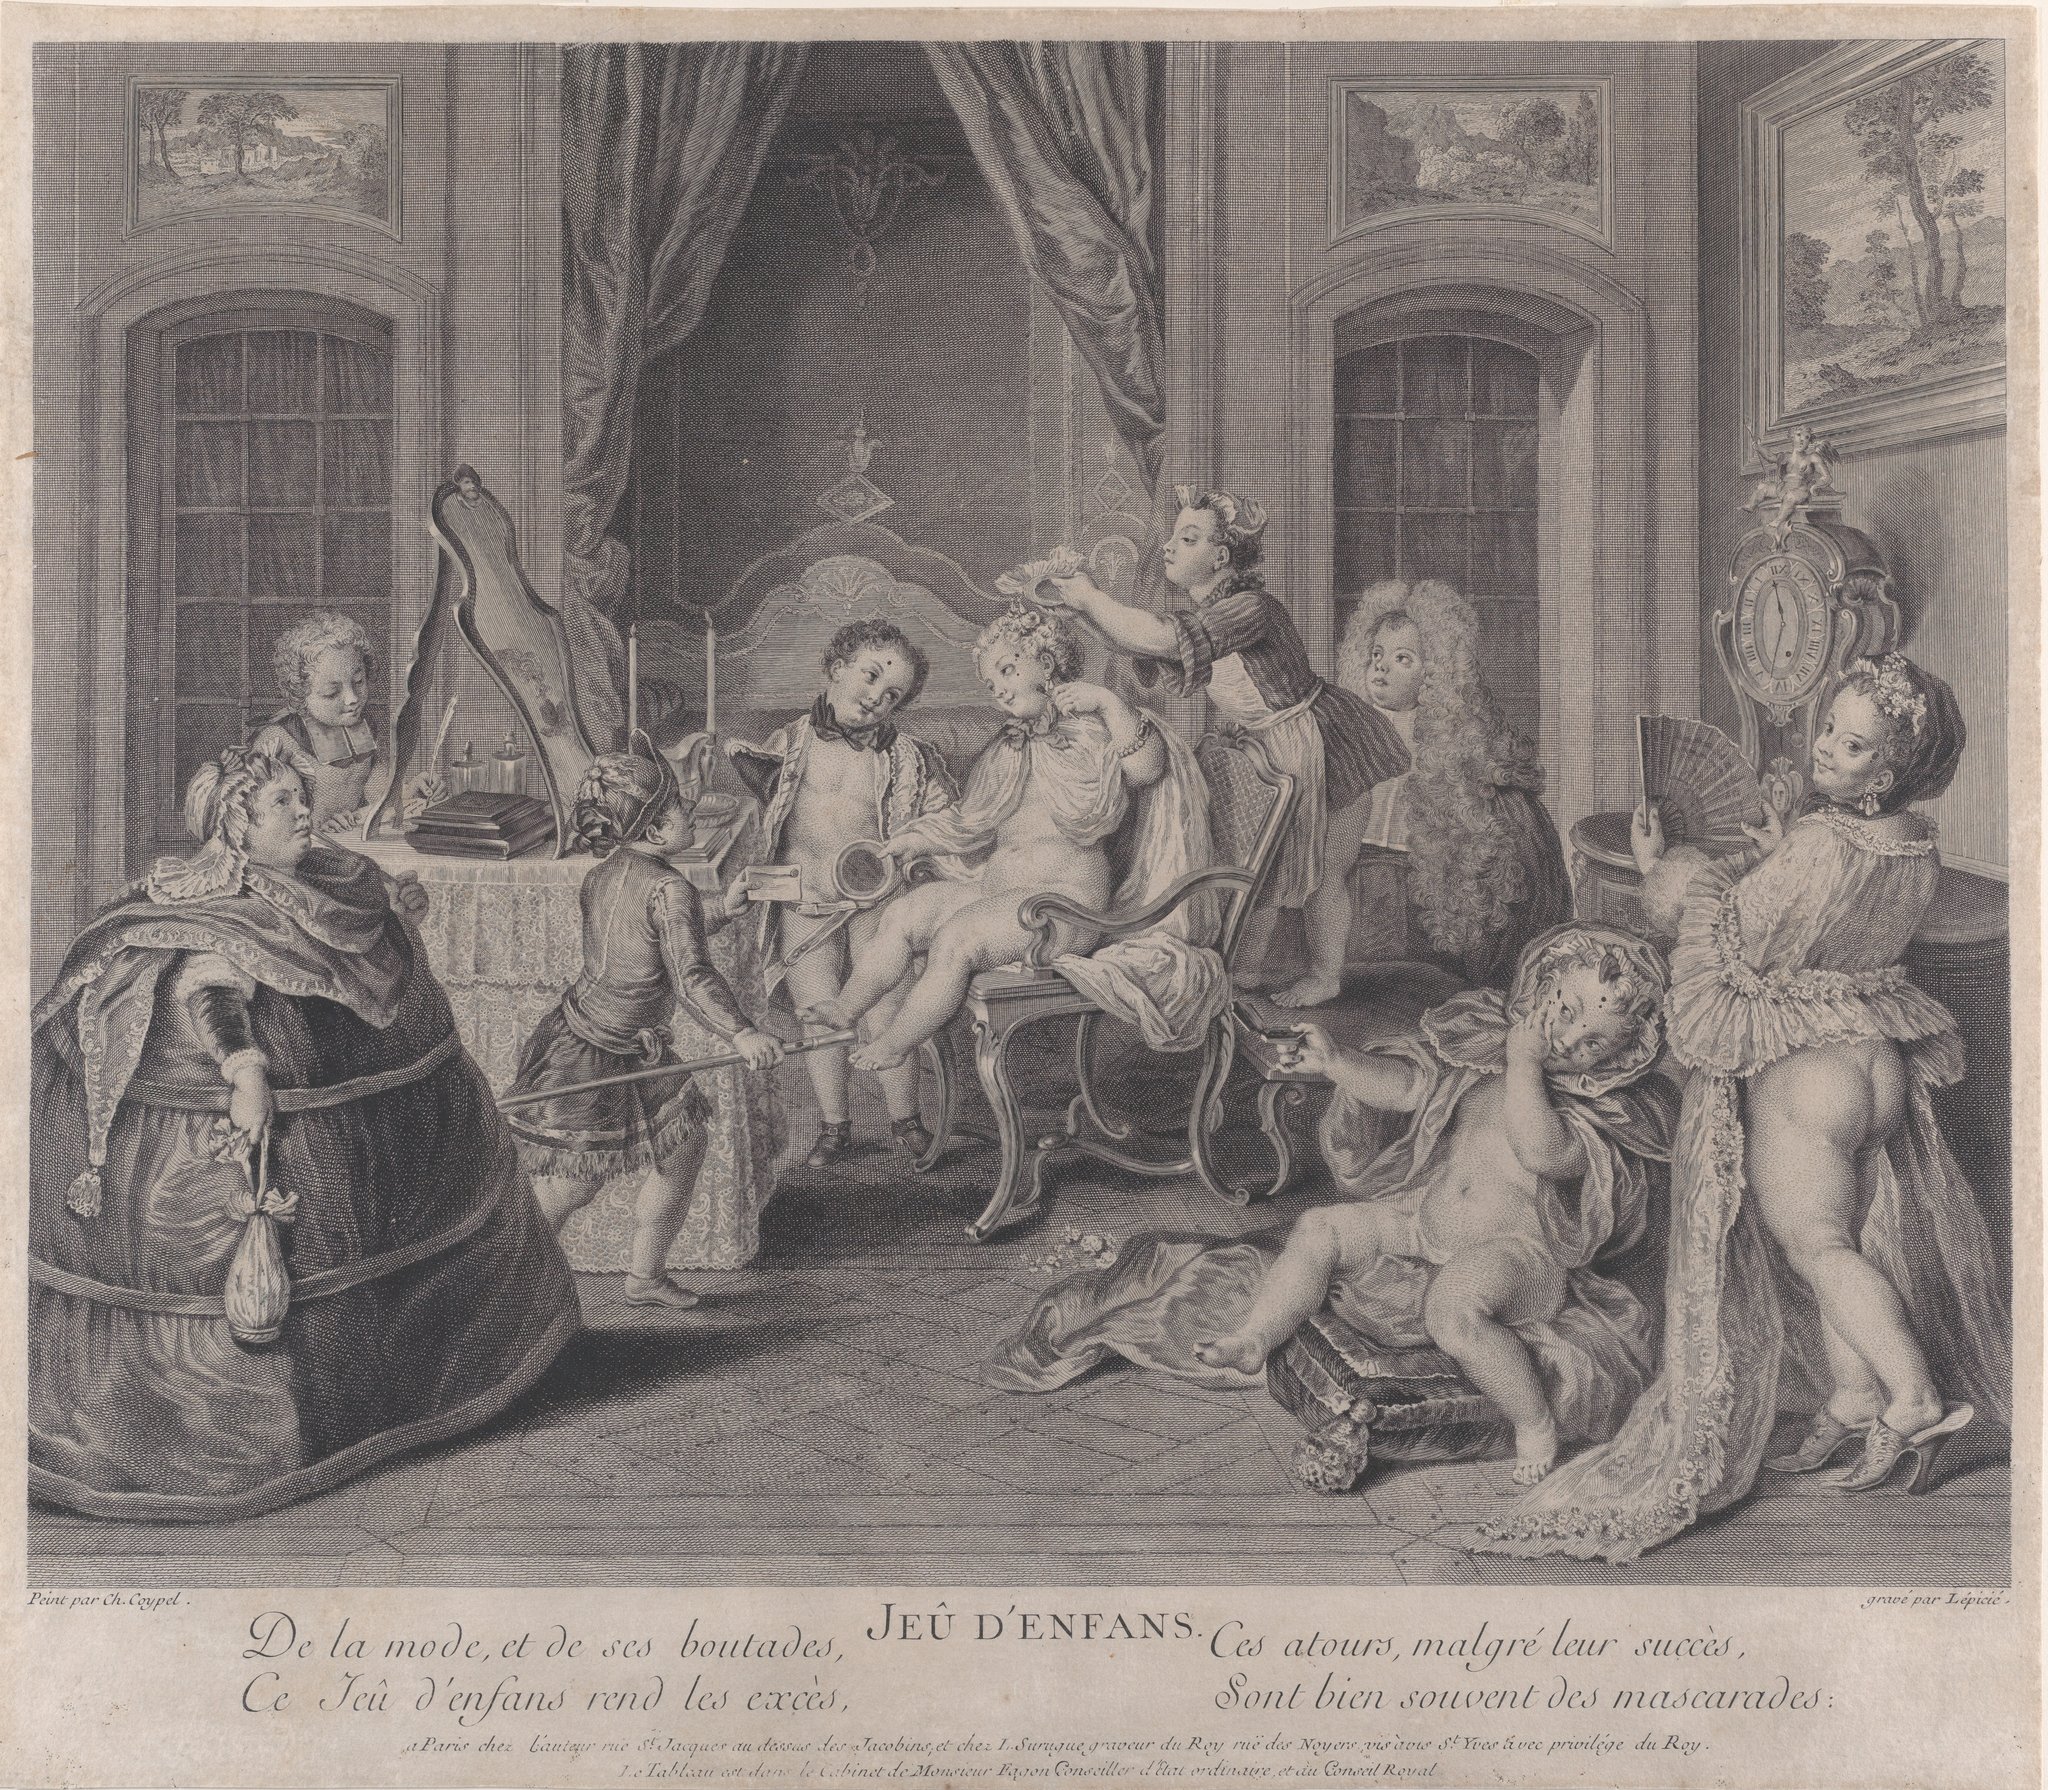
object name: print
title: Children's Games (Jeux des Enfants)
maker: bernard lepicié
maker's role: artist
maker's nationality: french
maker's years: 1698-1755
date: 1731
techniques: engraving, etching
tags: boys,girls,dressing